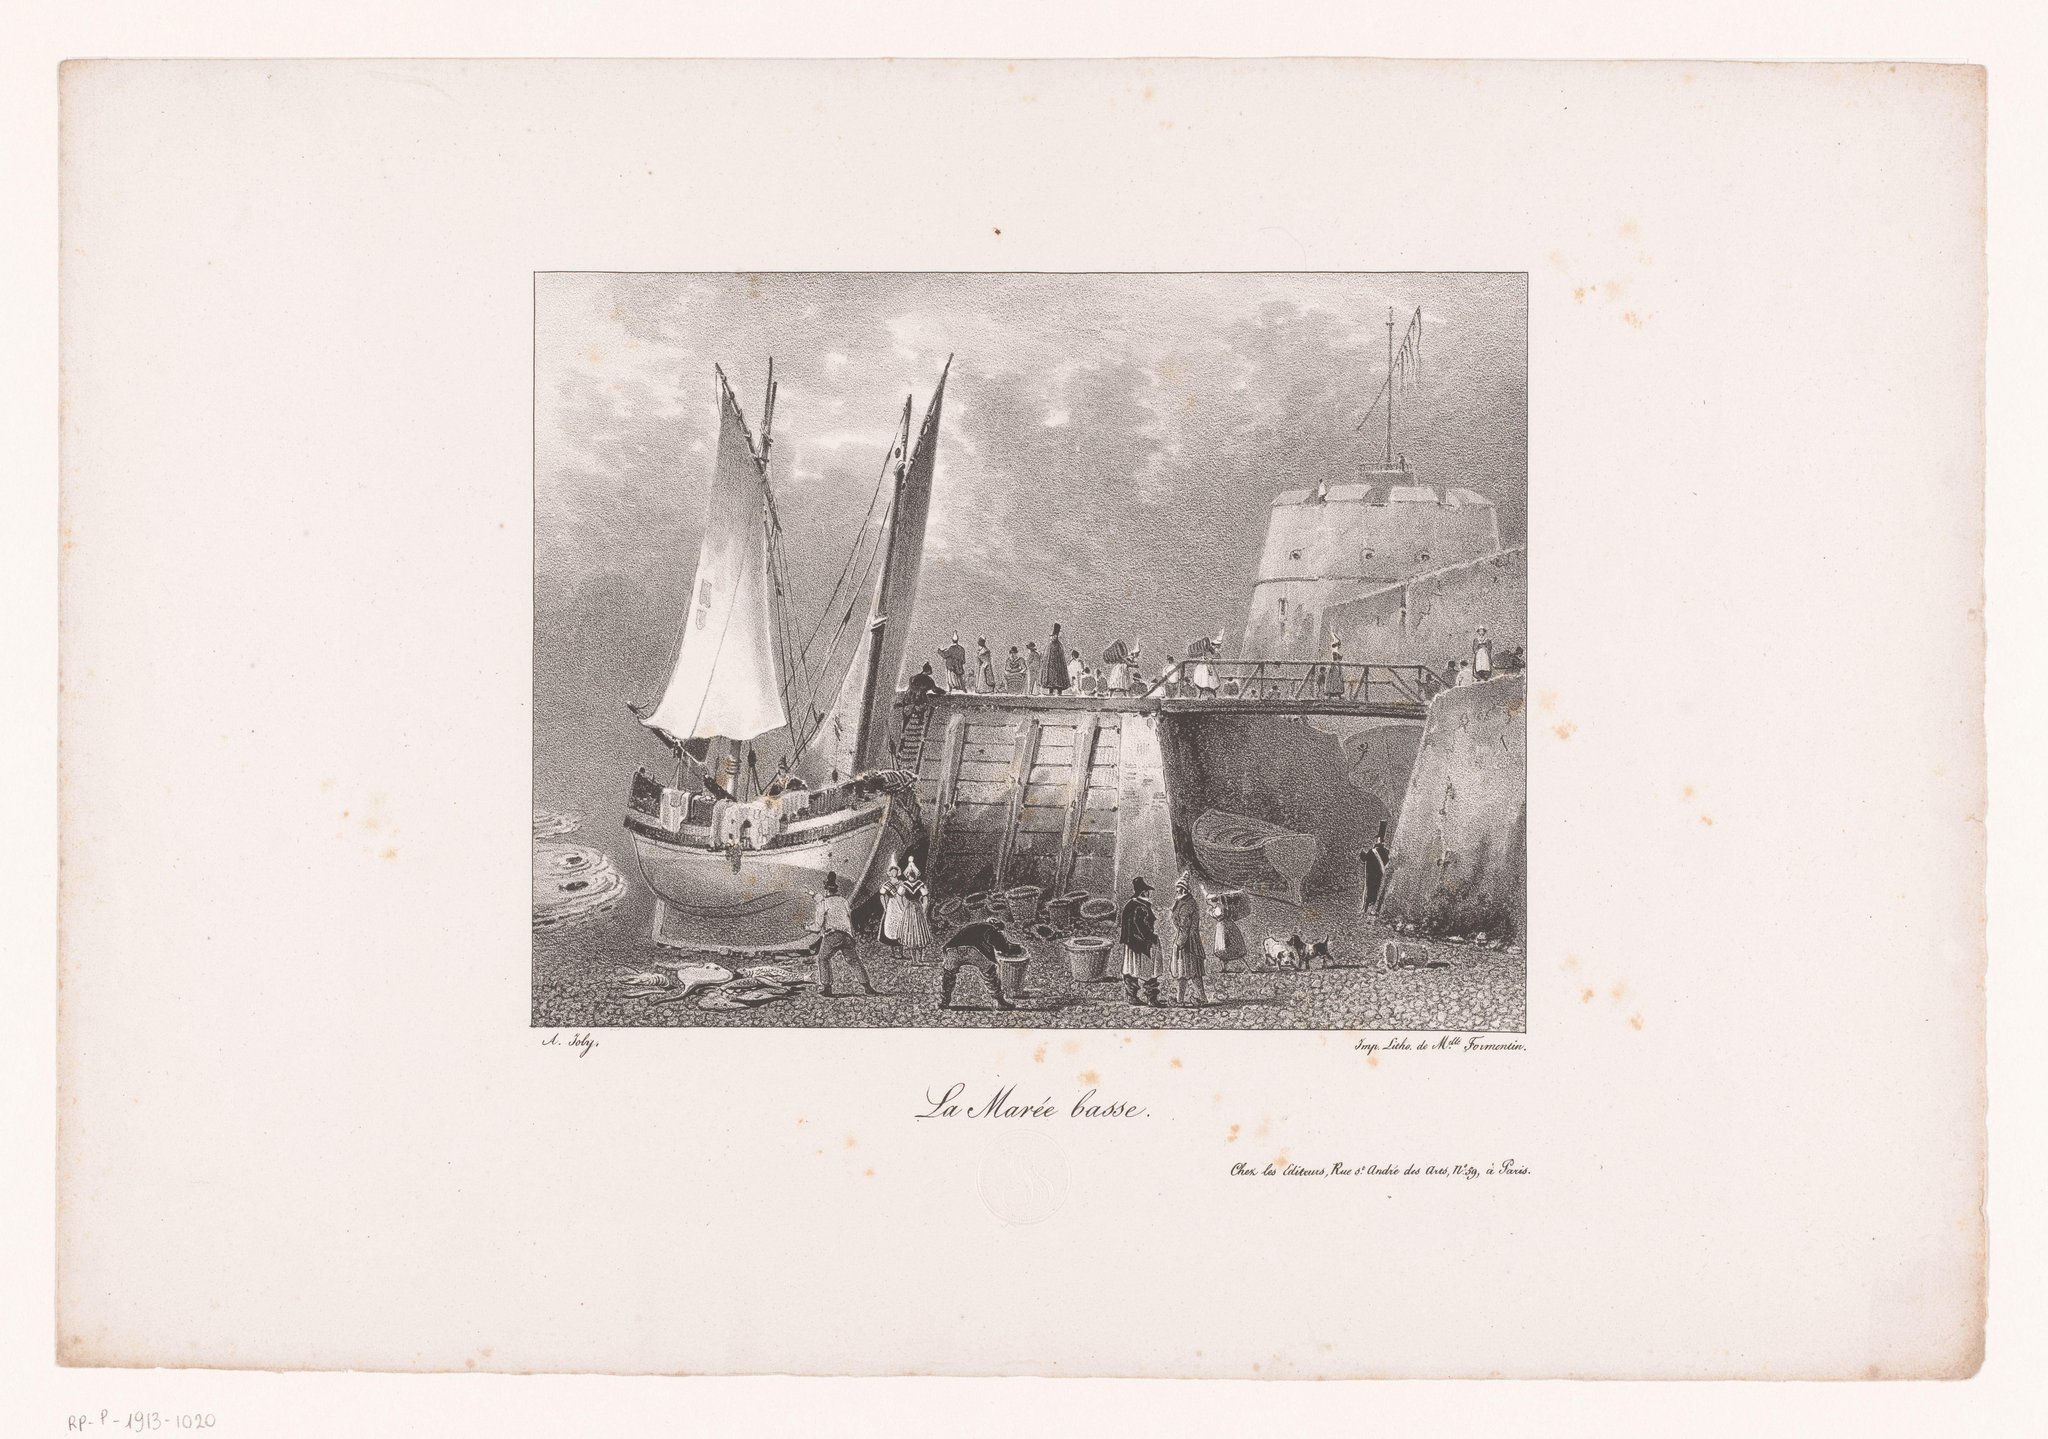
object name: print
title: La Marée basse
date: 1827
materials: paper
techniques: lithograph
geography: paris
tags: commercial fishery, sailing-ship, sailing-boat, ebb, low tide (+ landscape with figures, staffage), pier, quay, wharf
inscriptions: collector's mark: Lugt 2228a, check stamp: Lugt 3856